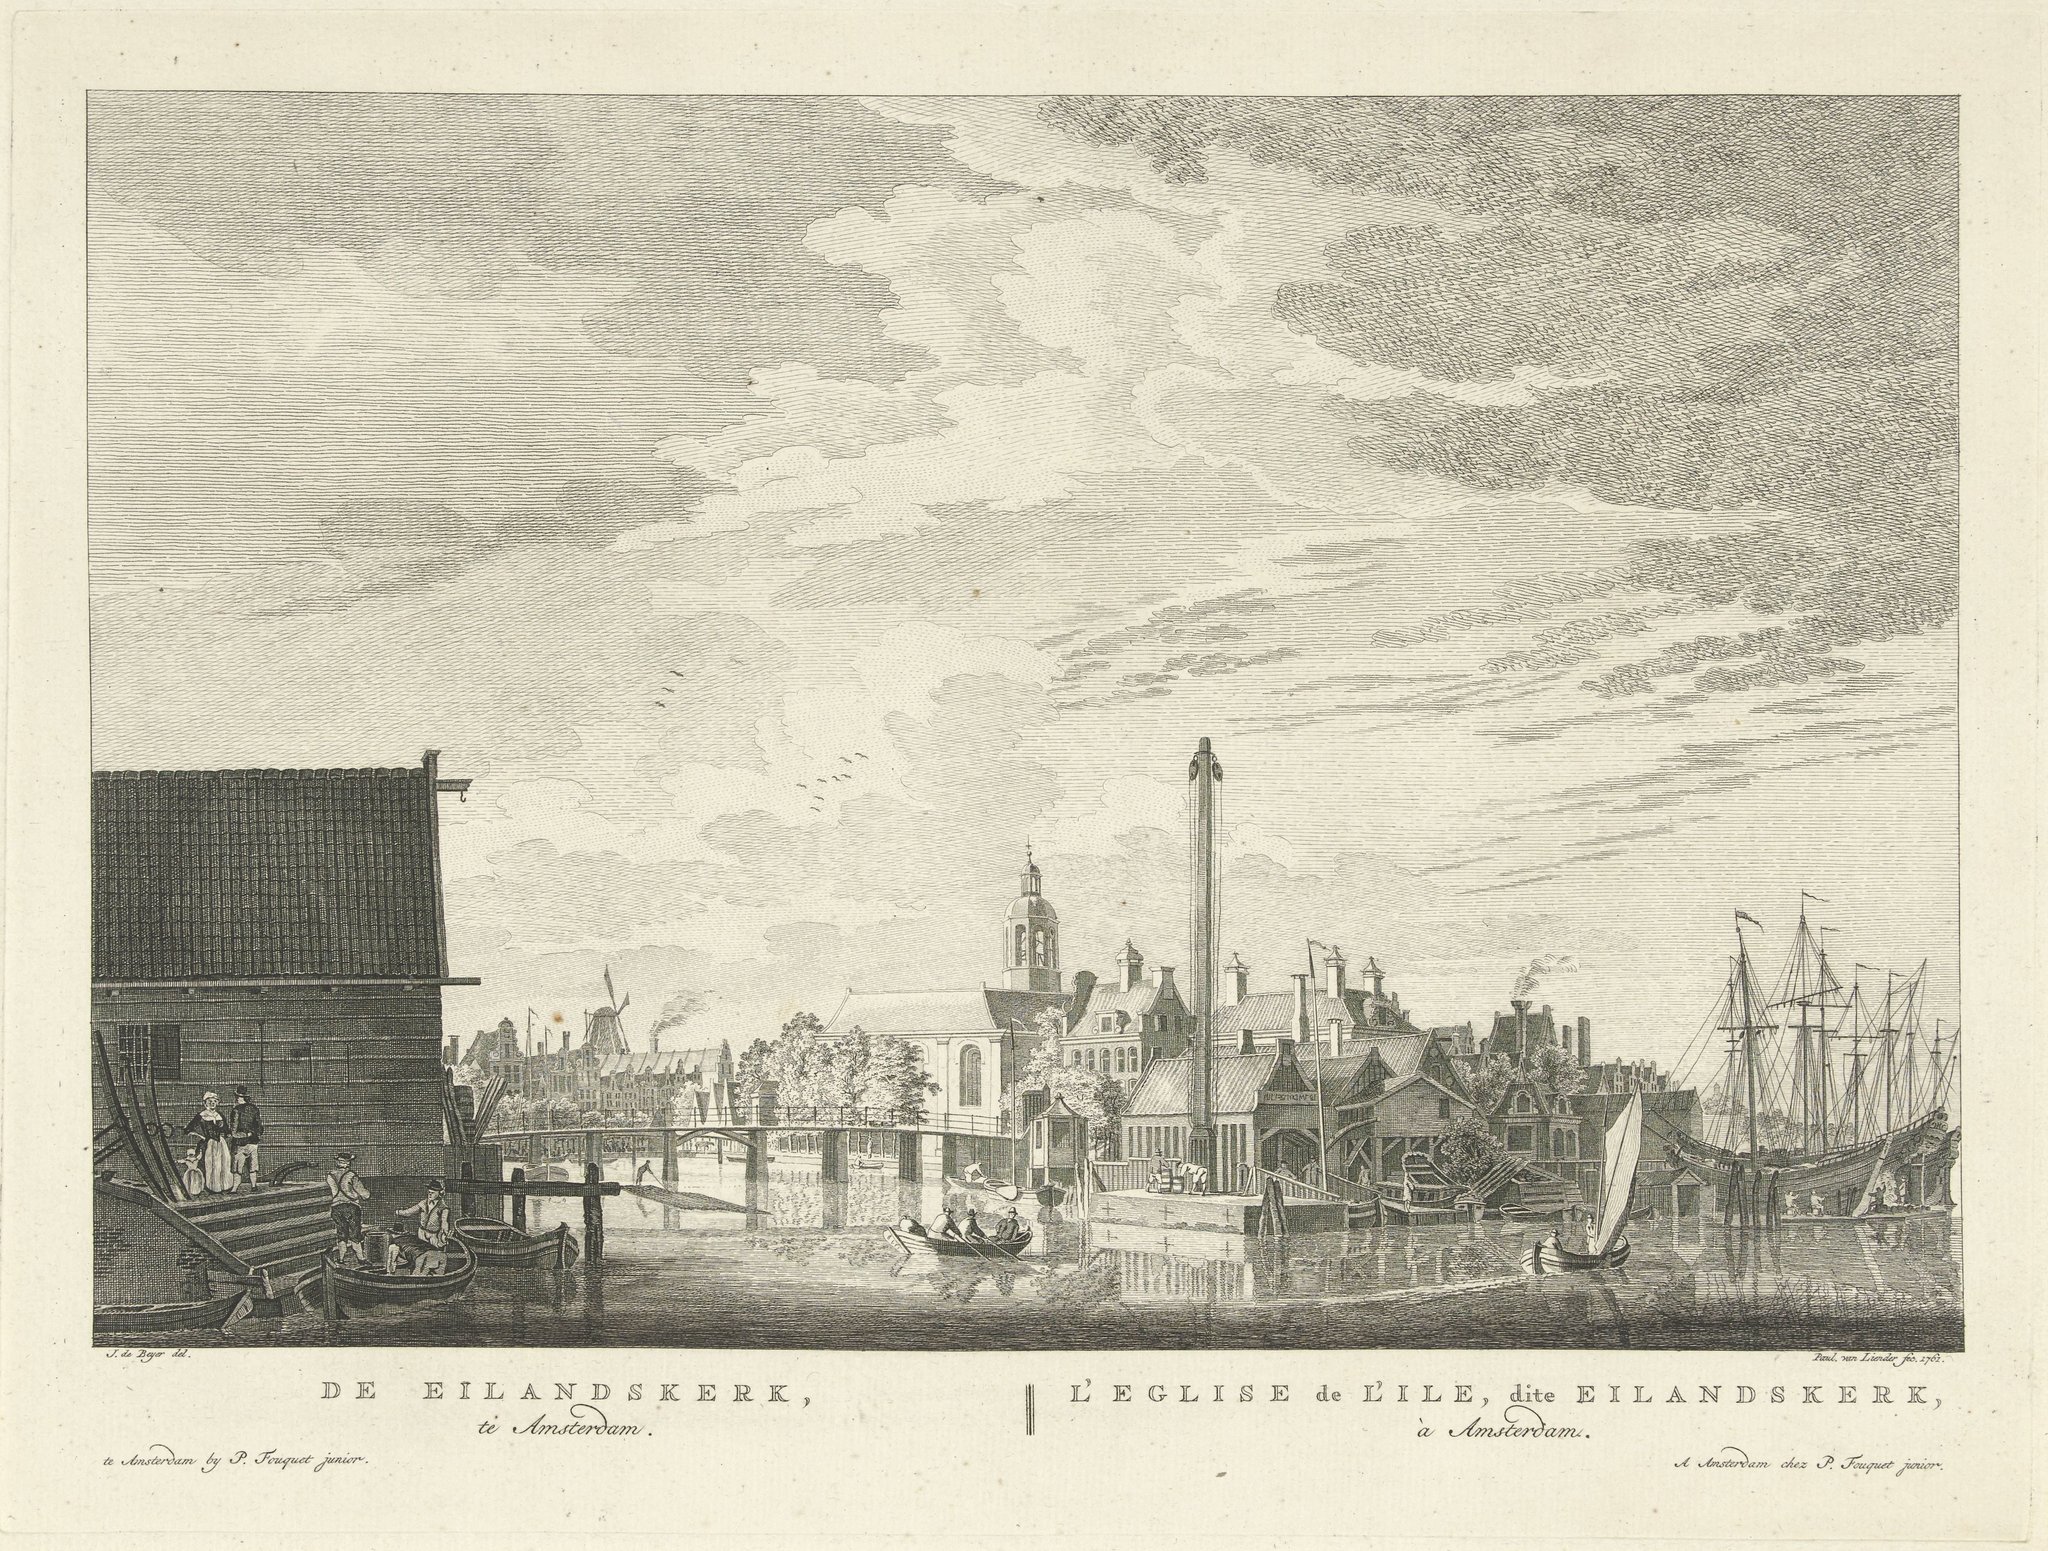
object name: print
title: Gezicht op de Eilandskerk te Amsterdam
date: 1761-1783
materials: paper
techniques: engraving, etching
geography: amsterdam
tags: ships (in general), church (exterior), canals, waters (in city), pier, quay, wharf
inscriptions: collector's mark: Lugt 2228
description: Deze prent is ook gebruikt in de zogenaamde Atlas van Fouquet.* Pierre Fouquet gaf vanaf 1760 stadsgezichten van Amsterdam - naar tekeningen van verschillende kunstenaars, gemaakt door verschillende prentmakers - uit. Deze prenten werden aanvankelijk los of in series verkocht. Zoals toen gebruikelijk kon de koper de prenten zelf laten inbinden. Hiertoe gaf Fouquet tussen 1778 en 1783 een titelblad, plattegrond en inhoudsopgave van de tot dusver 100 uitgegeven prenten uit (1). Gezien de inhoud afhankelijk was van wat de koper had verzameld verschilt de inhoud van de verschillende bewaarde Fouquetatlassen onder deze titel sterk. Ook zijn er exemplaren bekend waar tevens andere prenten aan zijn toegevoegd. Omdat er behoefte bleek aan uitleg bij de platen werd in 1783 een nieuwe versie van de atlas uitgegeven, aangevuld met tekst en twee prenten. De aangegeven volgorde veranderde maar de platen van de al eerder uitgegeven prenten bleven ongewijzigd. Deze uitgave werd in opdracht van Fouquet gedrukt bij Daniël Jean Changuion en Petrus den Hengst (2). Een tiental platen werd bijgewerkt en verscheen, met nieuw impressum, in het vervolg van Wagenaars geschiedenis van Amsterdam, uitgeven door Petrus Conradi en Folkert van der Plaats (3). Een aantal jaar na het overlijden van Fouquet kwam Evert Maaskamp met een nieuwe uitgave van de atlas, met verbeterde tekst en toevoeging van twee prenten. Op alle platen verwijderde hij het oude en liet hij zijn eigen impressum zetten (4). De huidige staat van de prent komt voor in exemplaren van de onder (1) en (2) genoemde werken. * Onder de Atlas van Fouquet of Fouquetatlas verstaan we de hieronder vermelde publicaties (1), (2) en (4). (1). Afbeeldingen van de wyd-vermaarde koopstad Amsterdam benevens des zelvs voornaamste gebouwen en gezigten alle naar het leeven getekend / Receuil des edifices les plus considerables et des plus belles vues, de la fameuse ville d'Amsterdam, dessinées d'après nature. Amsterdam: Pierre Fouquet, 1778-1783. (2). Nieuwe atlas, van de voornaamste gebouwen en gezigten der stad Amsterdam, met derzelver beknopte beschryvingen. 2 delen. Amsterdam: Daniël Jean Changuion en Petrus den Hengst [in opdracht van Pierre Fouquet], 1783. (3). Stijl, Simon. Amsterdam, in zyne geschiedenissen, voorregten, koophandel, gebouwen, kerkenstaat, schoolen, schutterye, gilden en regeeringe, beschreeven. Om te dienen ten vervolge op het werk van Jan Wagenaar (…). 10 delen. Amsterdam en Harlingen: Petrus Conradi en Folkert van der Plaats, 1788-1801. (4). Nieuwe atlas, van de voornaamste gebouwen en gezigten der stad Amsterdam. Met derzelver beknopte beschryvingen. Amsterdam: Evert Maaskamp, 1805. * Het aantal vermelde staten is gebaseerd op het aantal gevonden staten. Mogelijk zijn er meer staten van deze prent. Voor eerste bekende staat zie RP-P-AO-23-61. Voor derde bekende staat zie RP-P-AO-23-61A. Voor vierde bekende staat zie RP-P-1998-777.